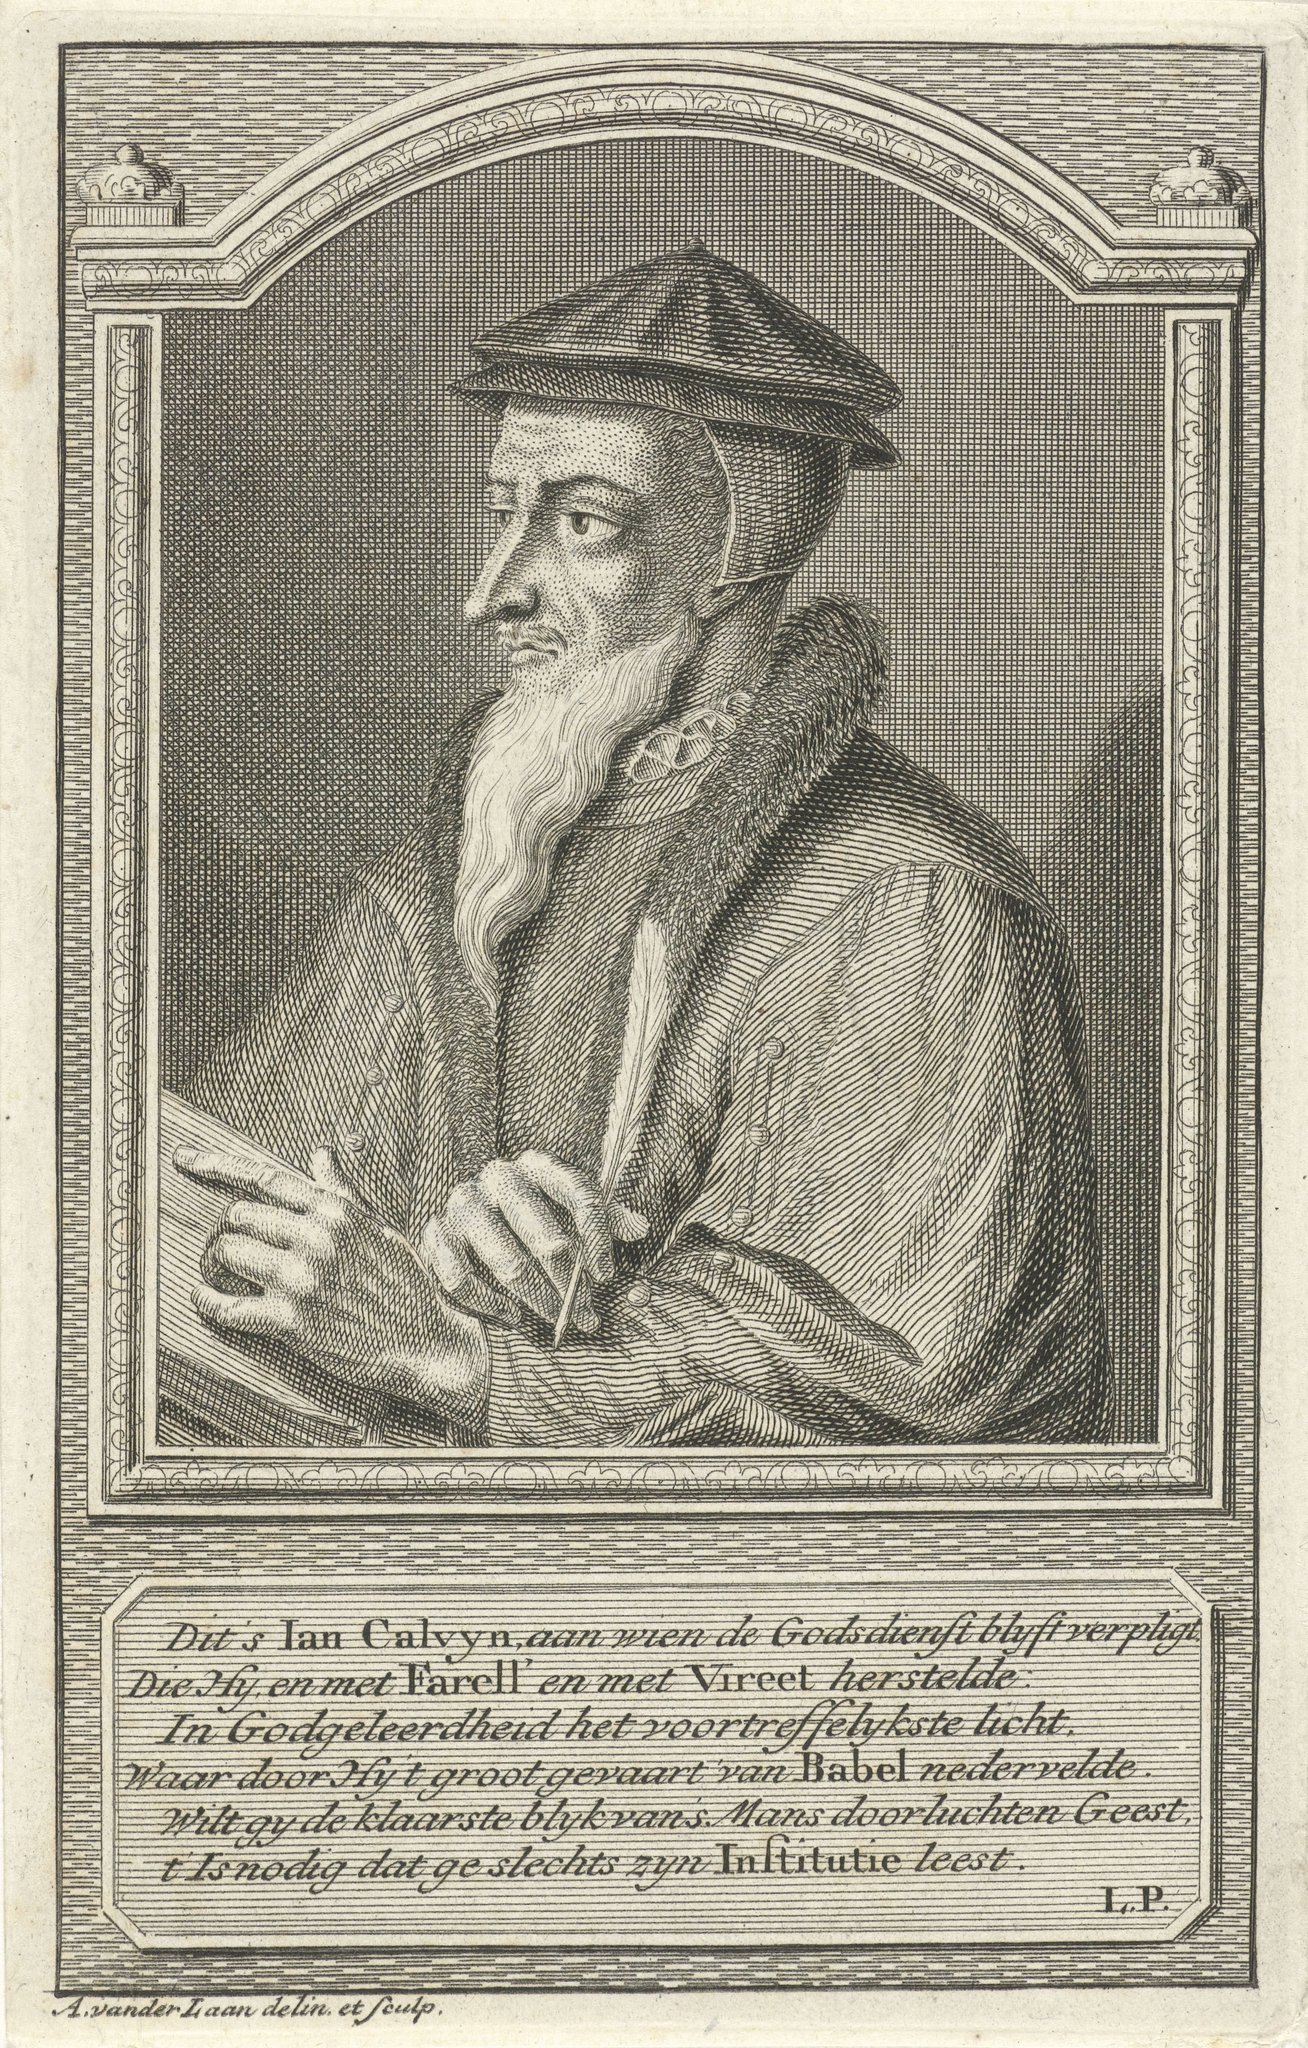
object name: print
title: Portret van Johannes Calvijn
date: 1694-1755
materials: paper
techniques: engraving, etching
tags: noyon, genève, theoloog, hervormer, johannes calvijn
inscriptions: collector's mark: Lugt 2228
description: Portretbuste naar links van de kerkhervormer Johannes Calvijn, met hoofddeksel. Zijn linkerhand rust op een opgeslagen boek, in zijn rechterhand een schrijfveer. Rondom een ornamentele omlijsting, onder het portret een zesregelig Nederlands vers.